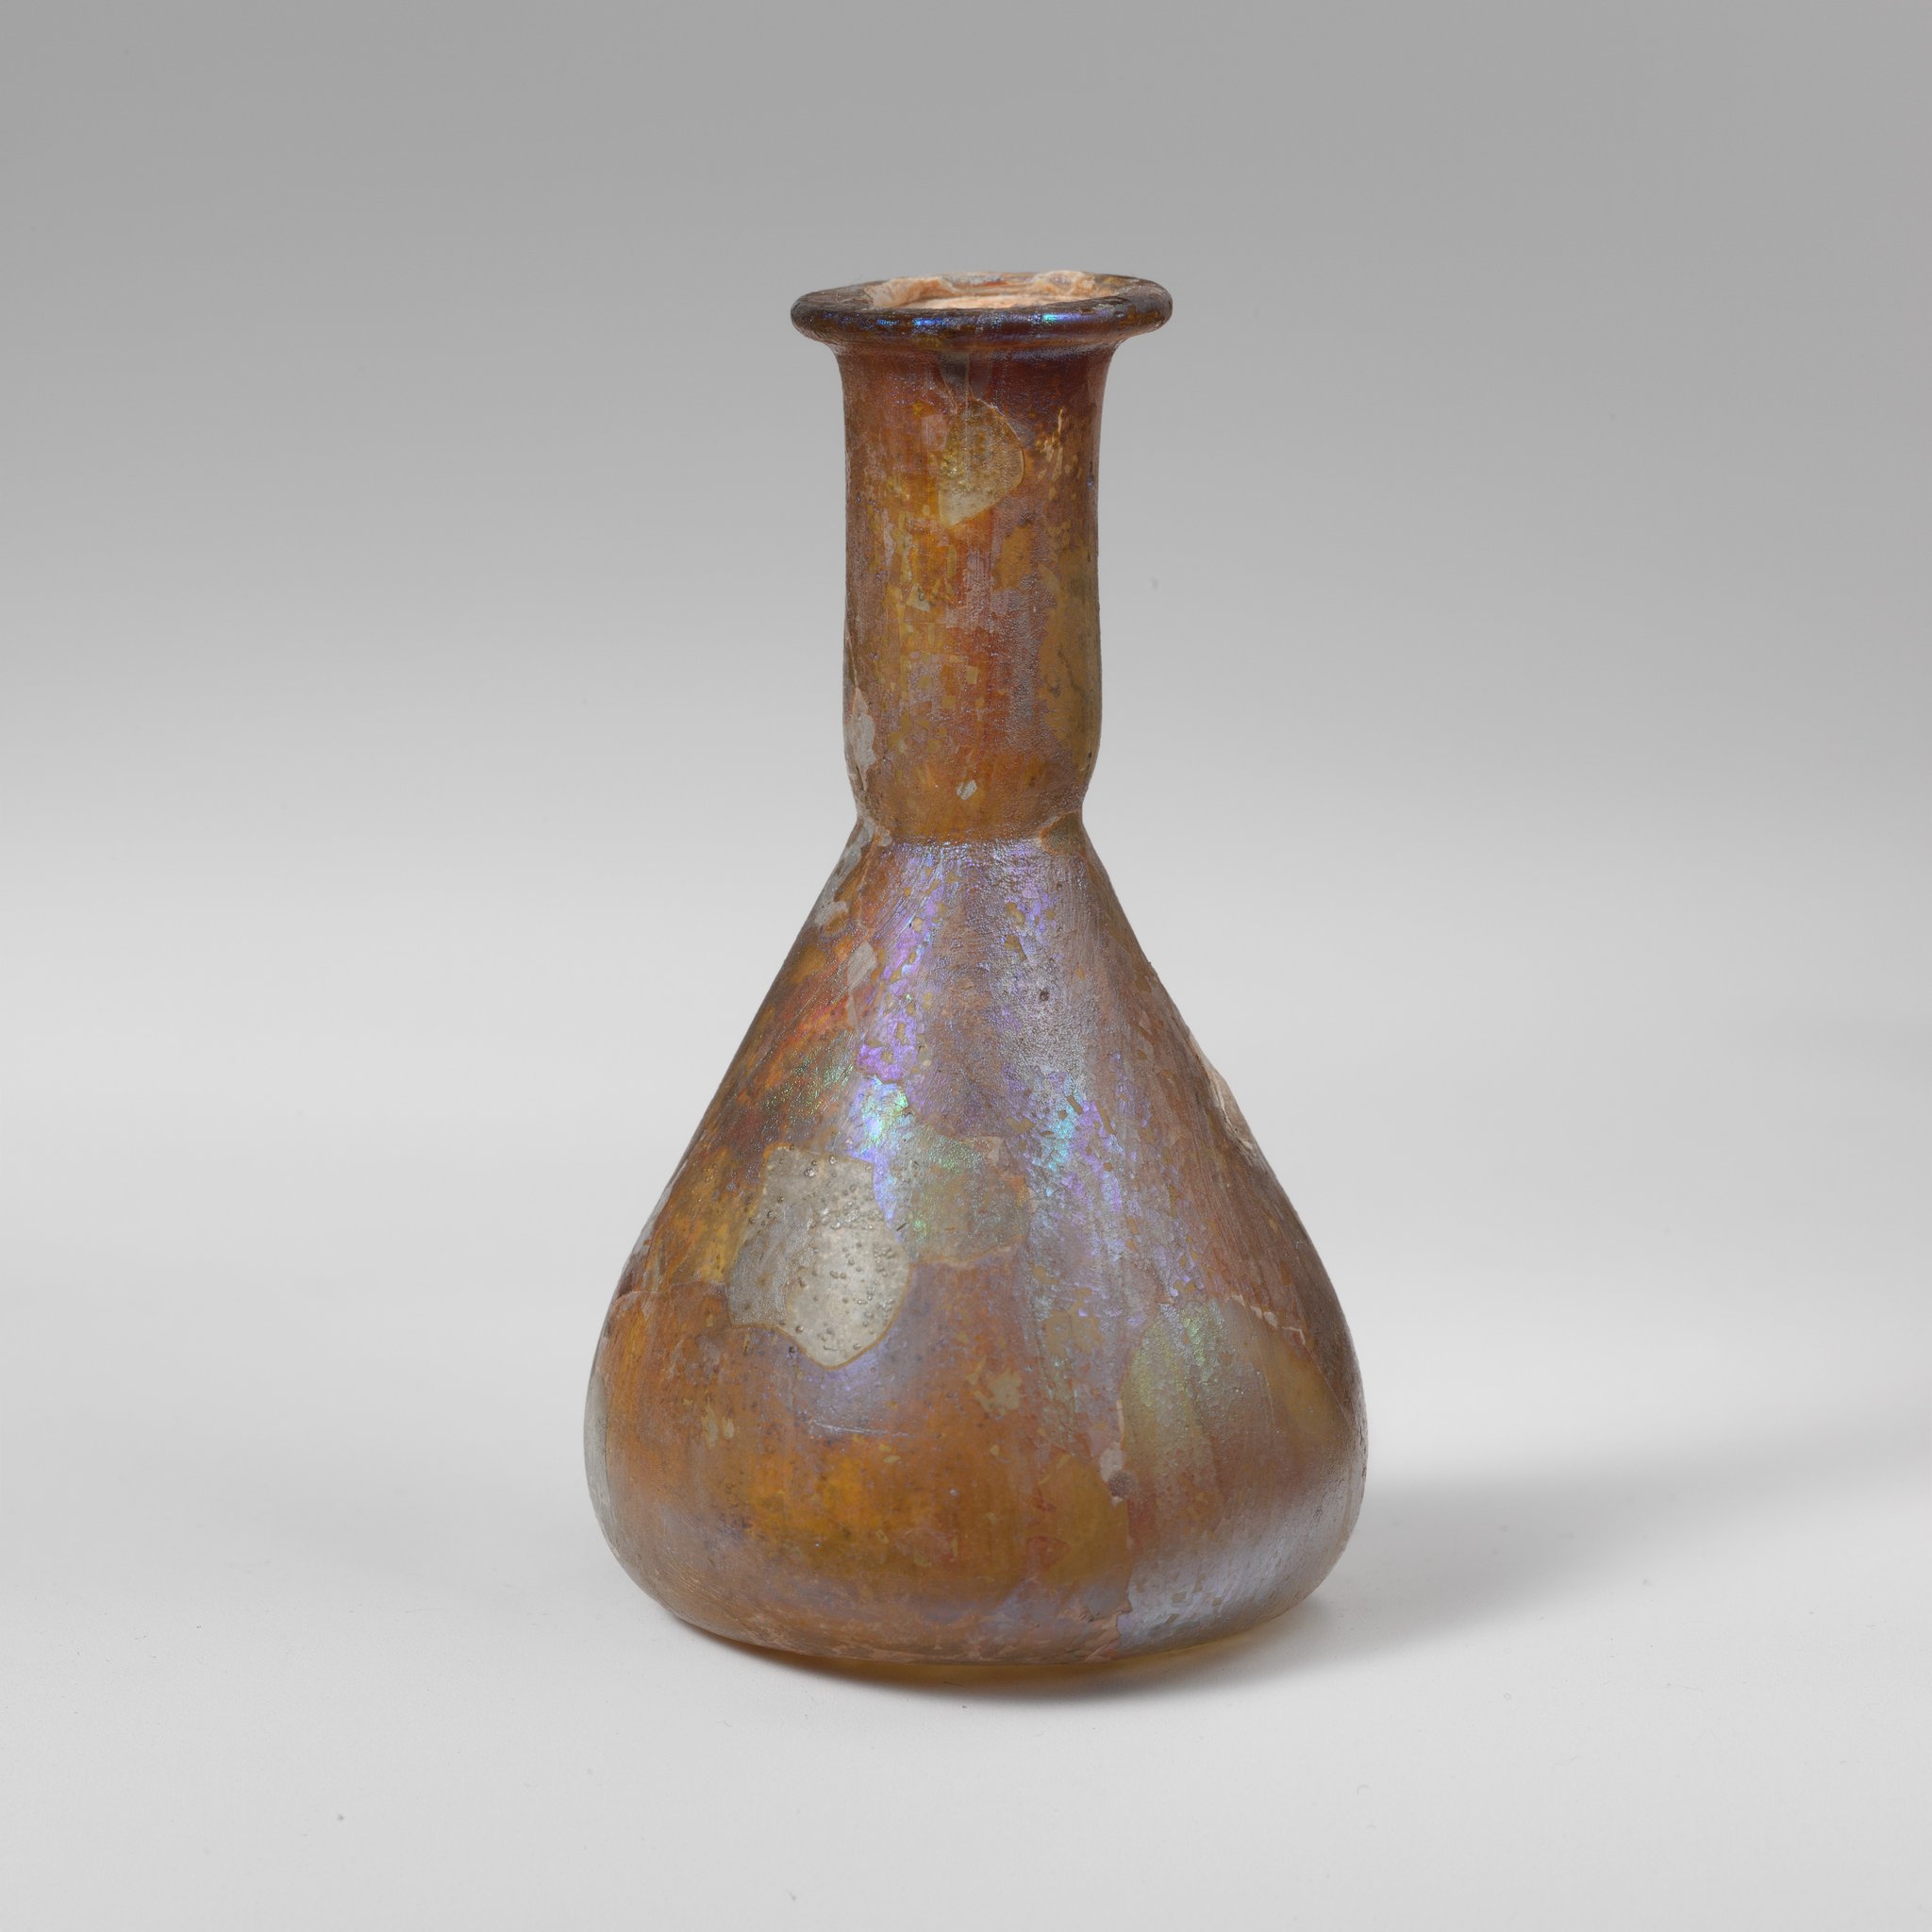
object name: perfume bottle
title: Glass perfume bottle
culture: roman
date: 101-300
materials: glass